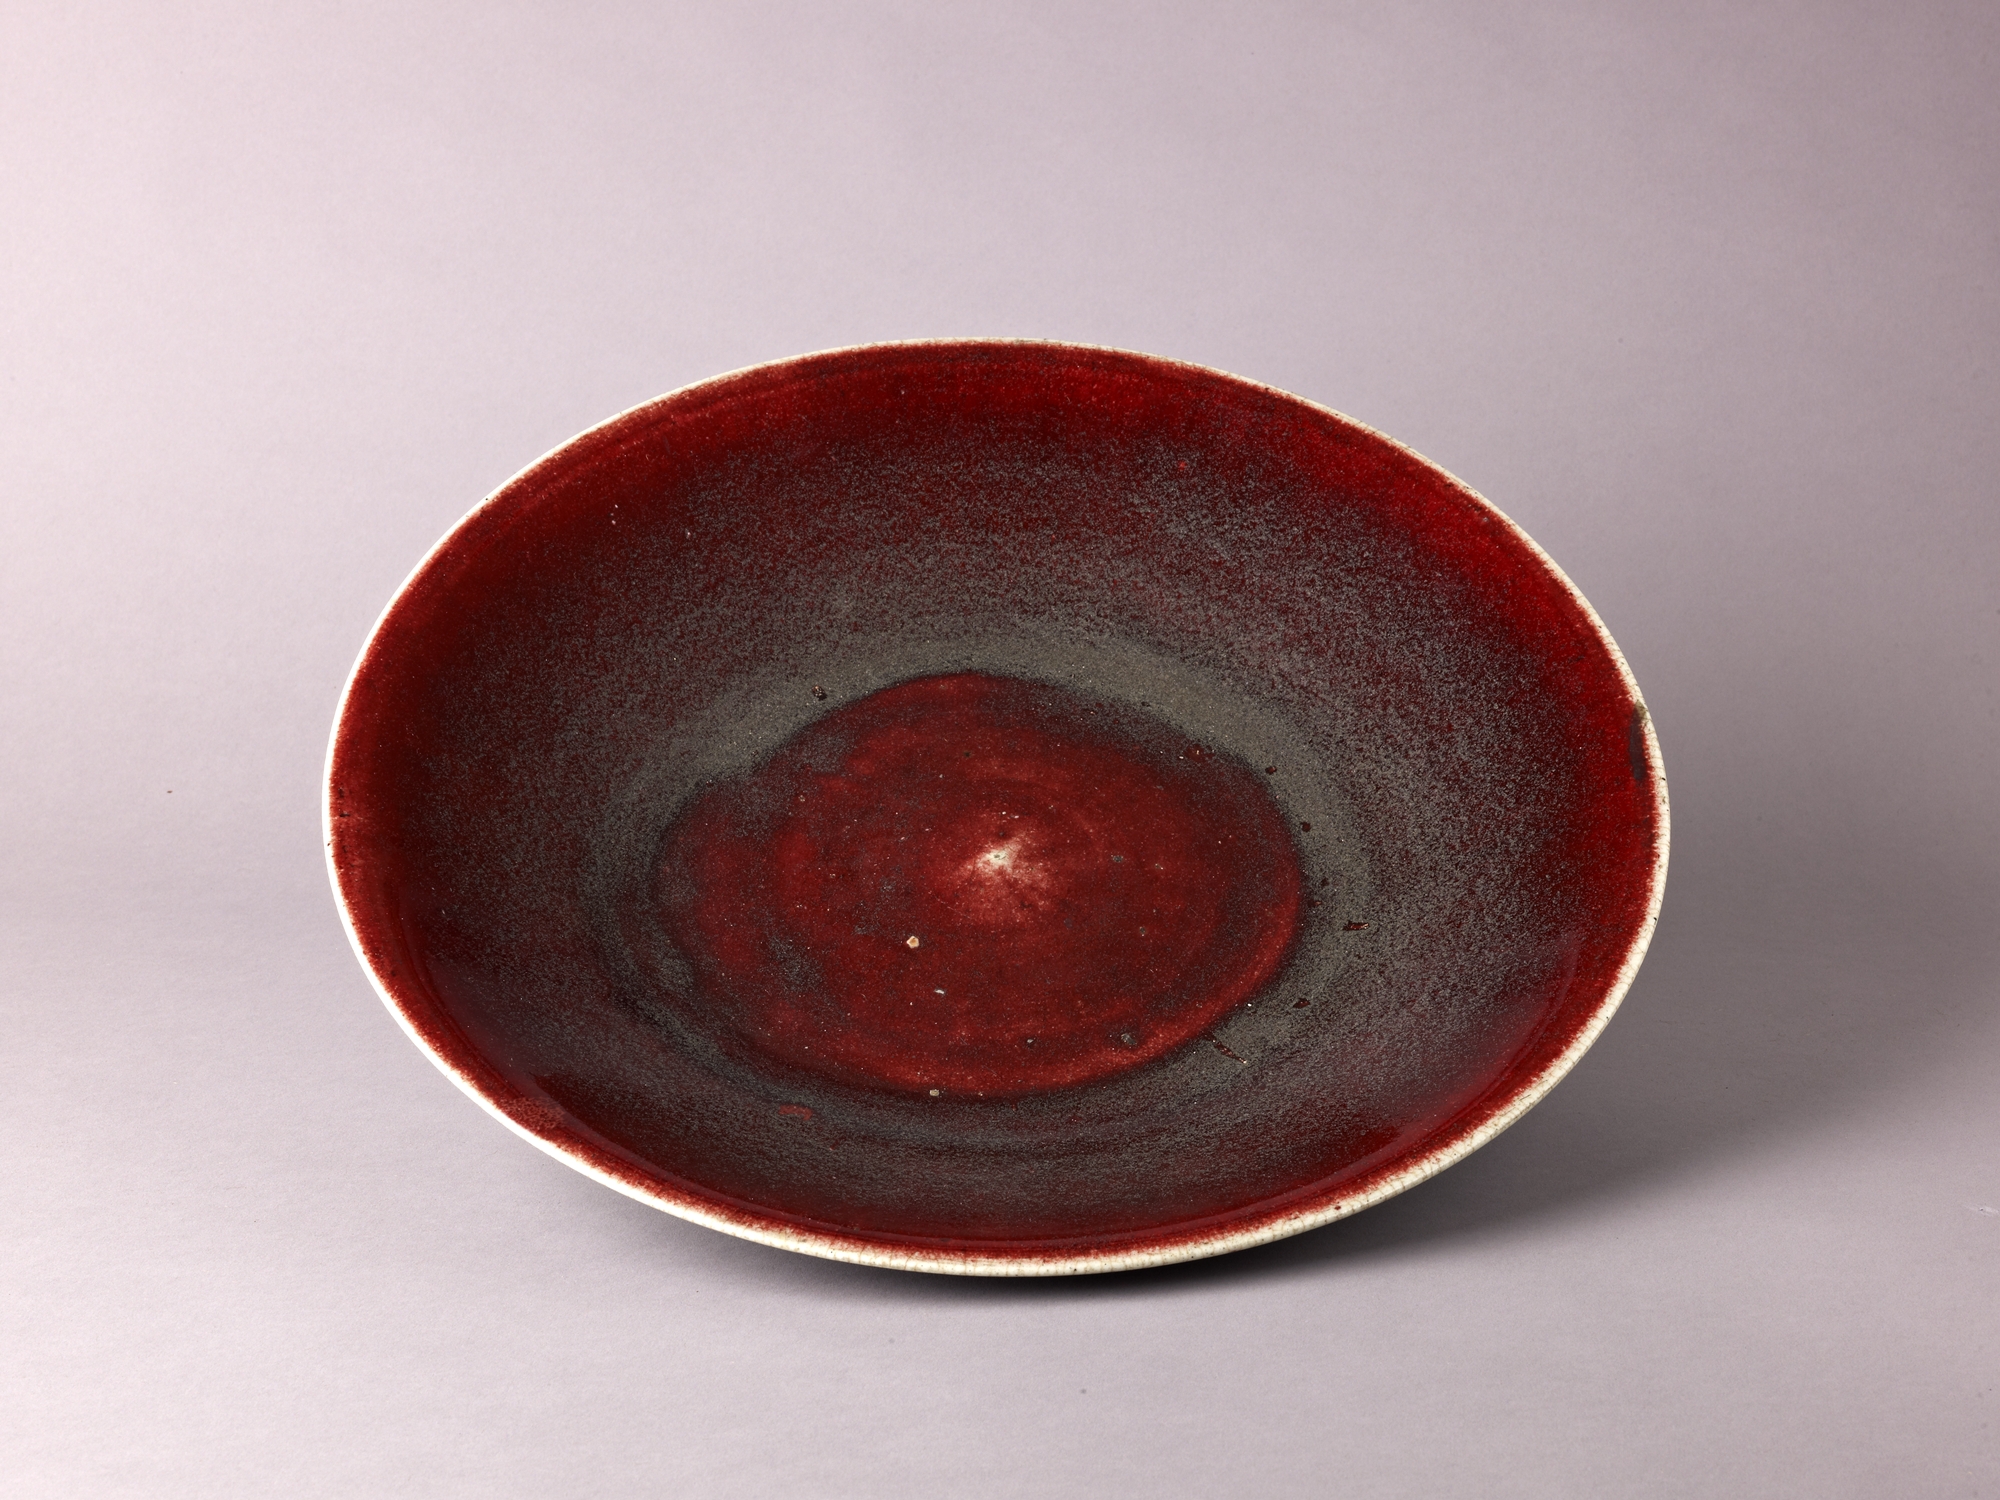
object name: dish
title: Large dish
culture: chinese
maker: chinese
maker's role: artist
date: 1801-1900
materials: glaze, porcelain